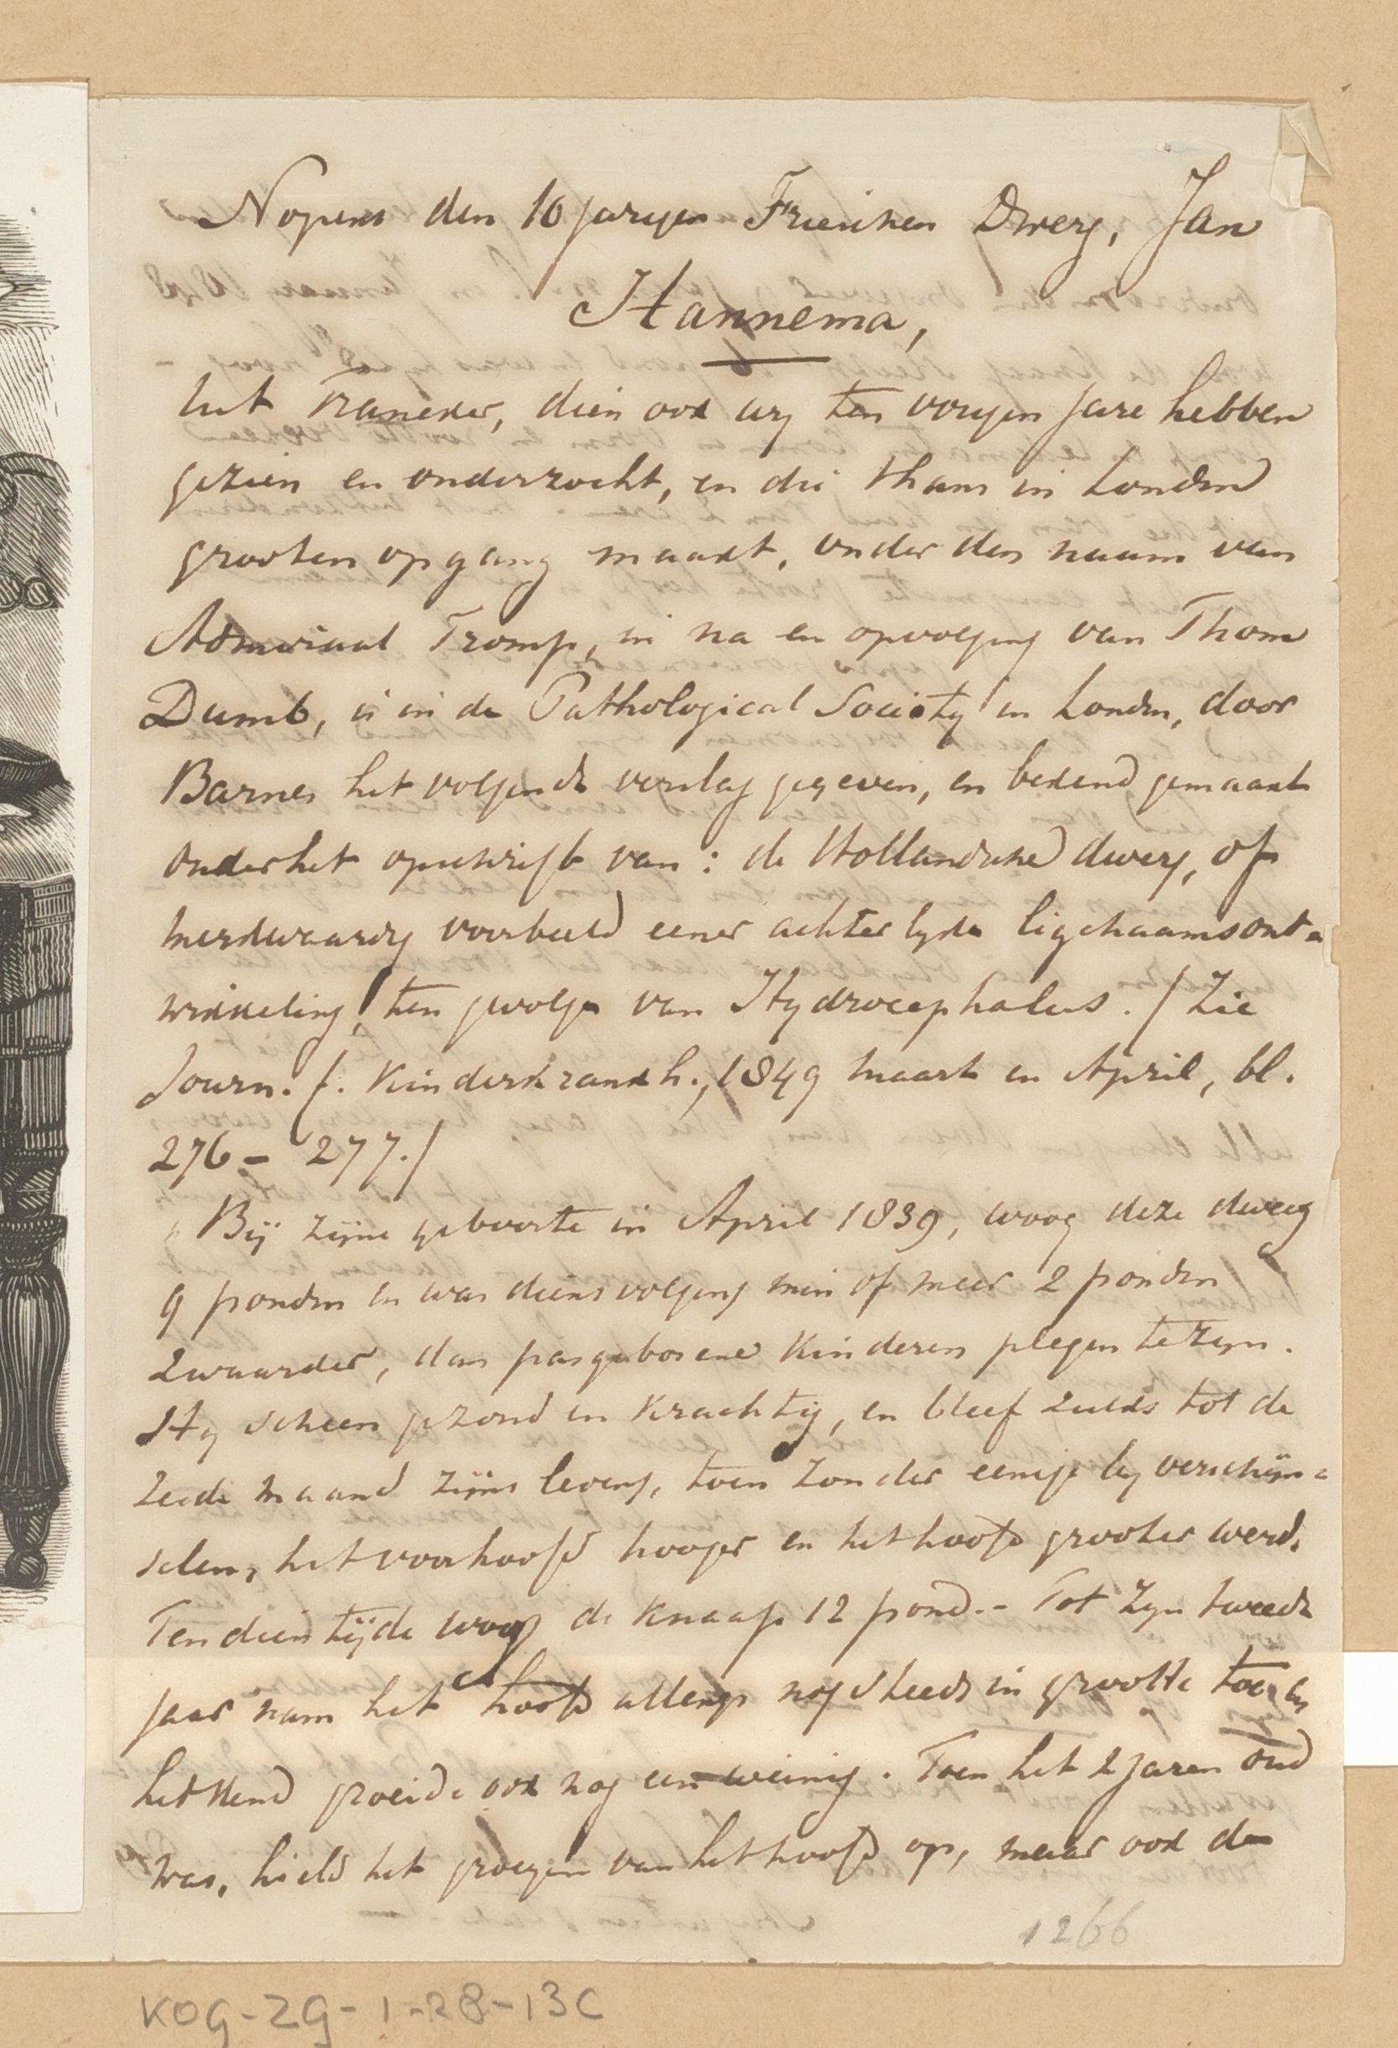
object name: manuscript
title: Beschrijving van Jan Hannema, alias admiraal Tom Pouce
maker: Anonymous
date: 1849-1878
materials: ink, paper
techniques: pen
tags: jan hannema, portrait of actor, actress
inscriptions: stamp, stamp, collector's mark: Lugt 1641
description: Onderwerpsrubrieken binnen de Atlas Zeden en Gewoonten: Zeden en Gewoonten in Engeren Zin. Volksleven. Volksfeesten. Kermistypen, wondermenschen en dergelijken.